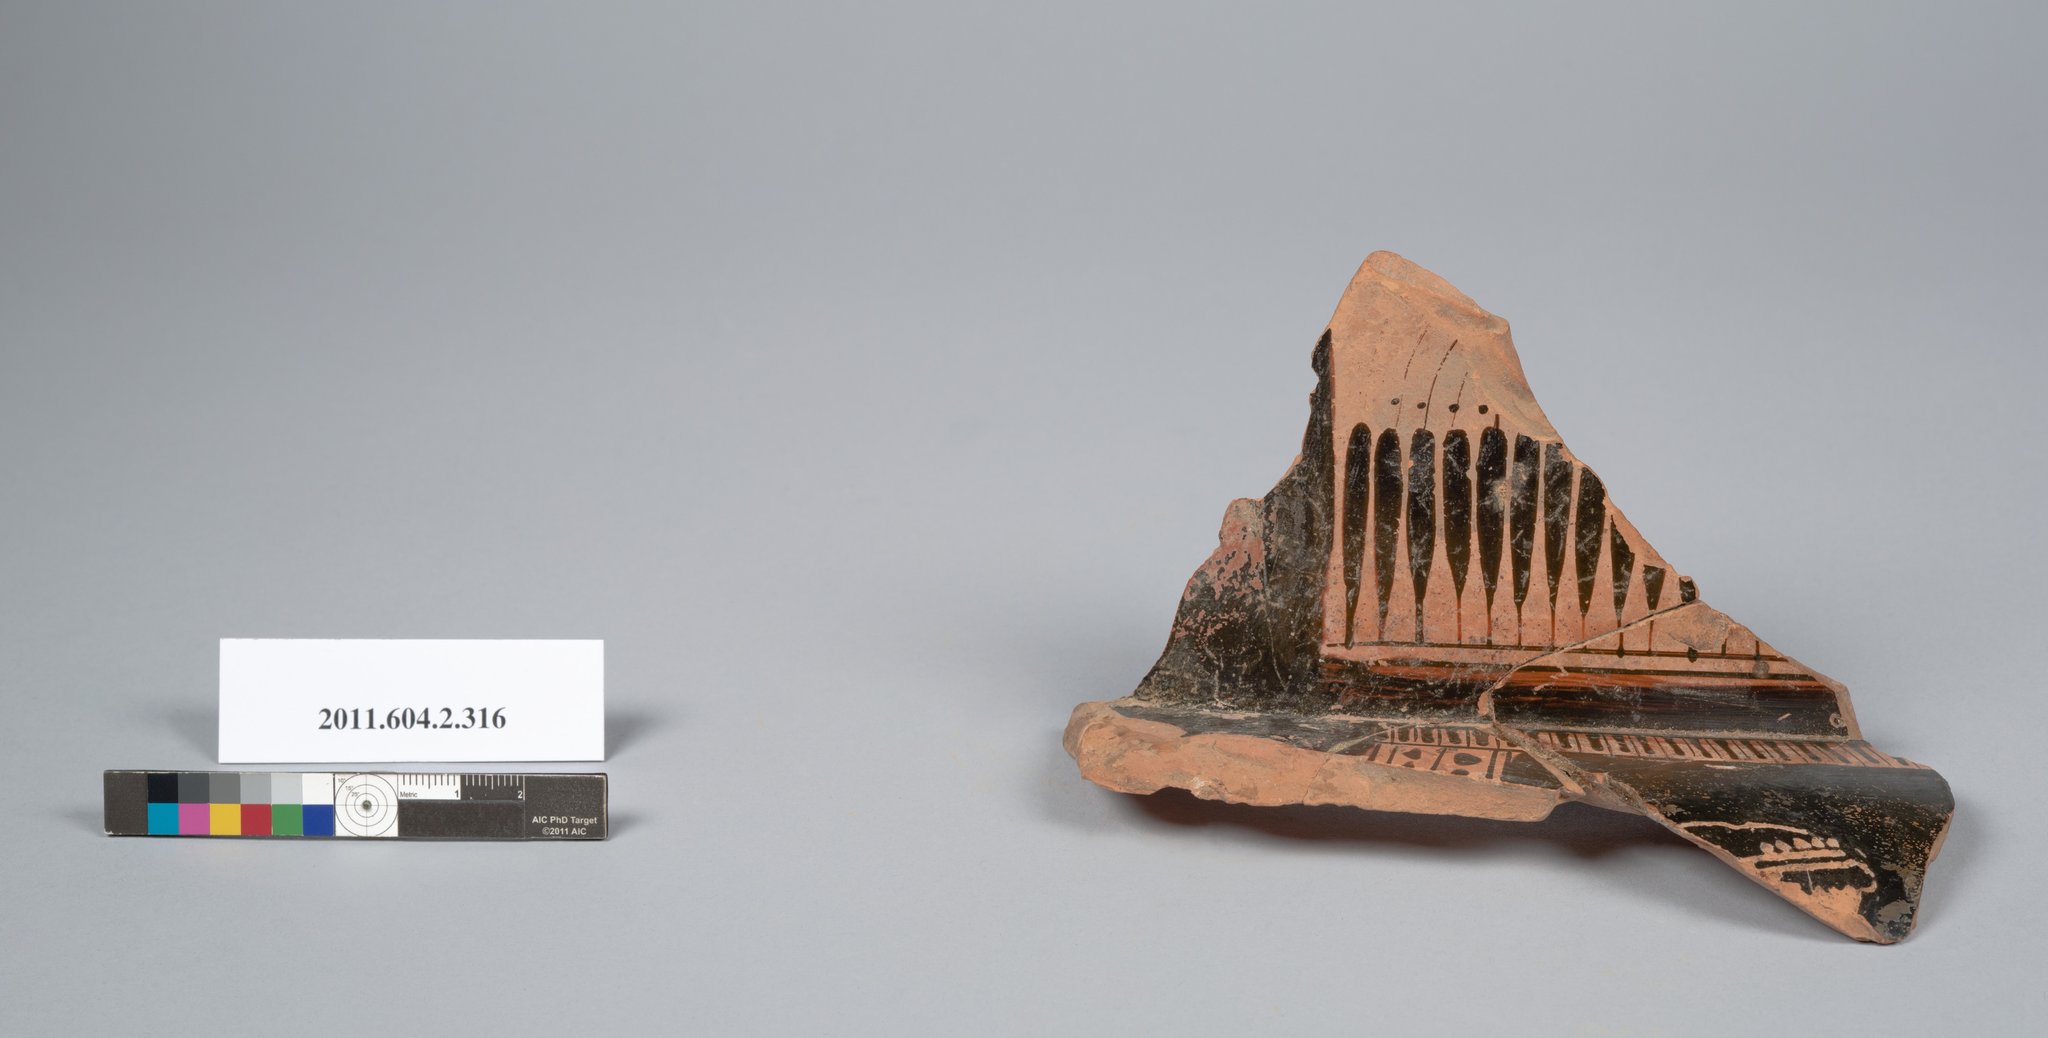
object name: column krater fragment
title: Terracotta fragment of a column-krater (bowl for mixing wine and water)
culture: greek, attic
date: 460-440 BCE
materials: terracotta